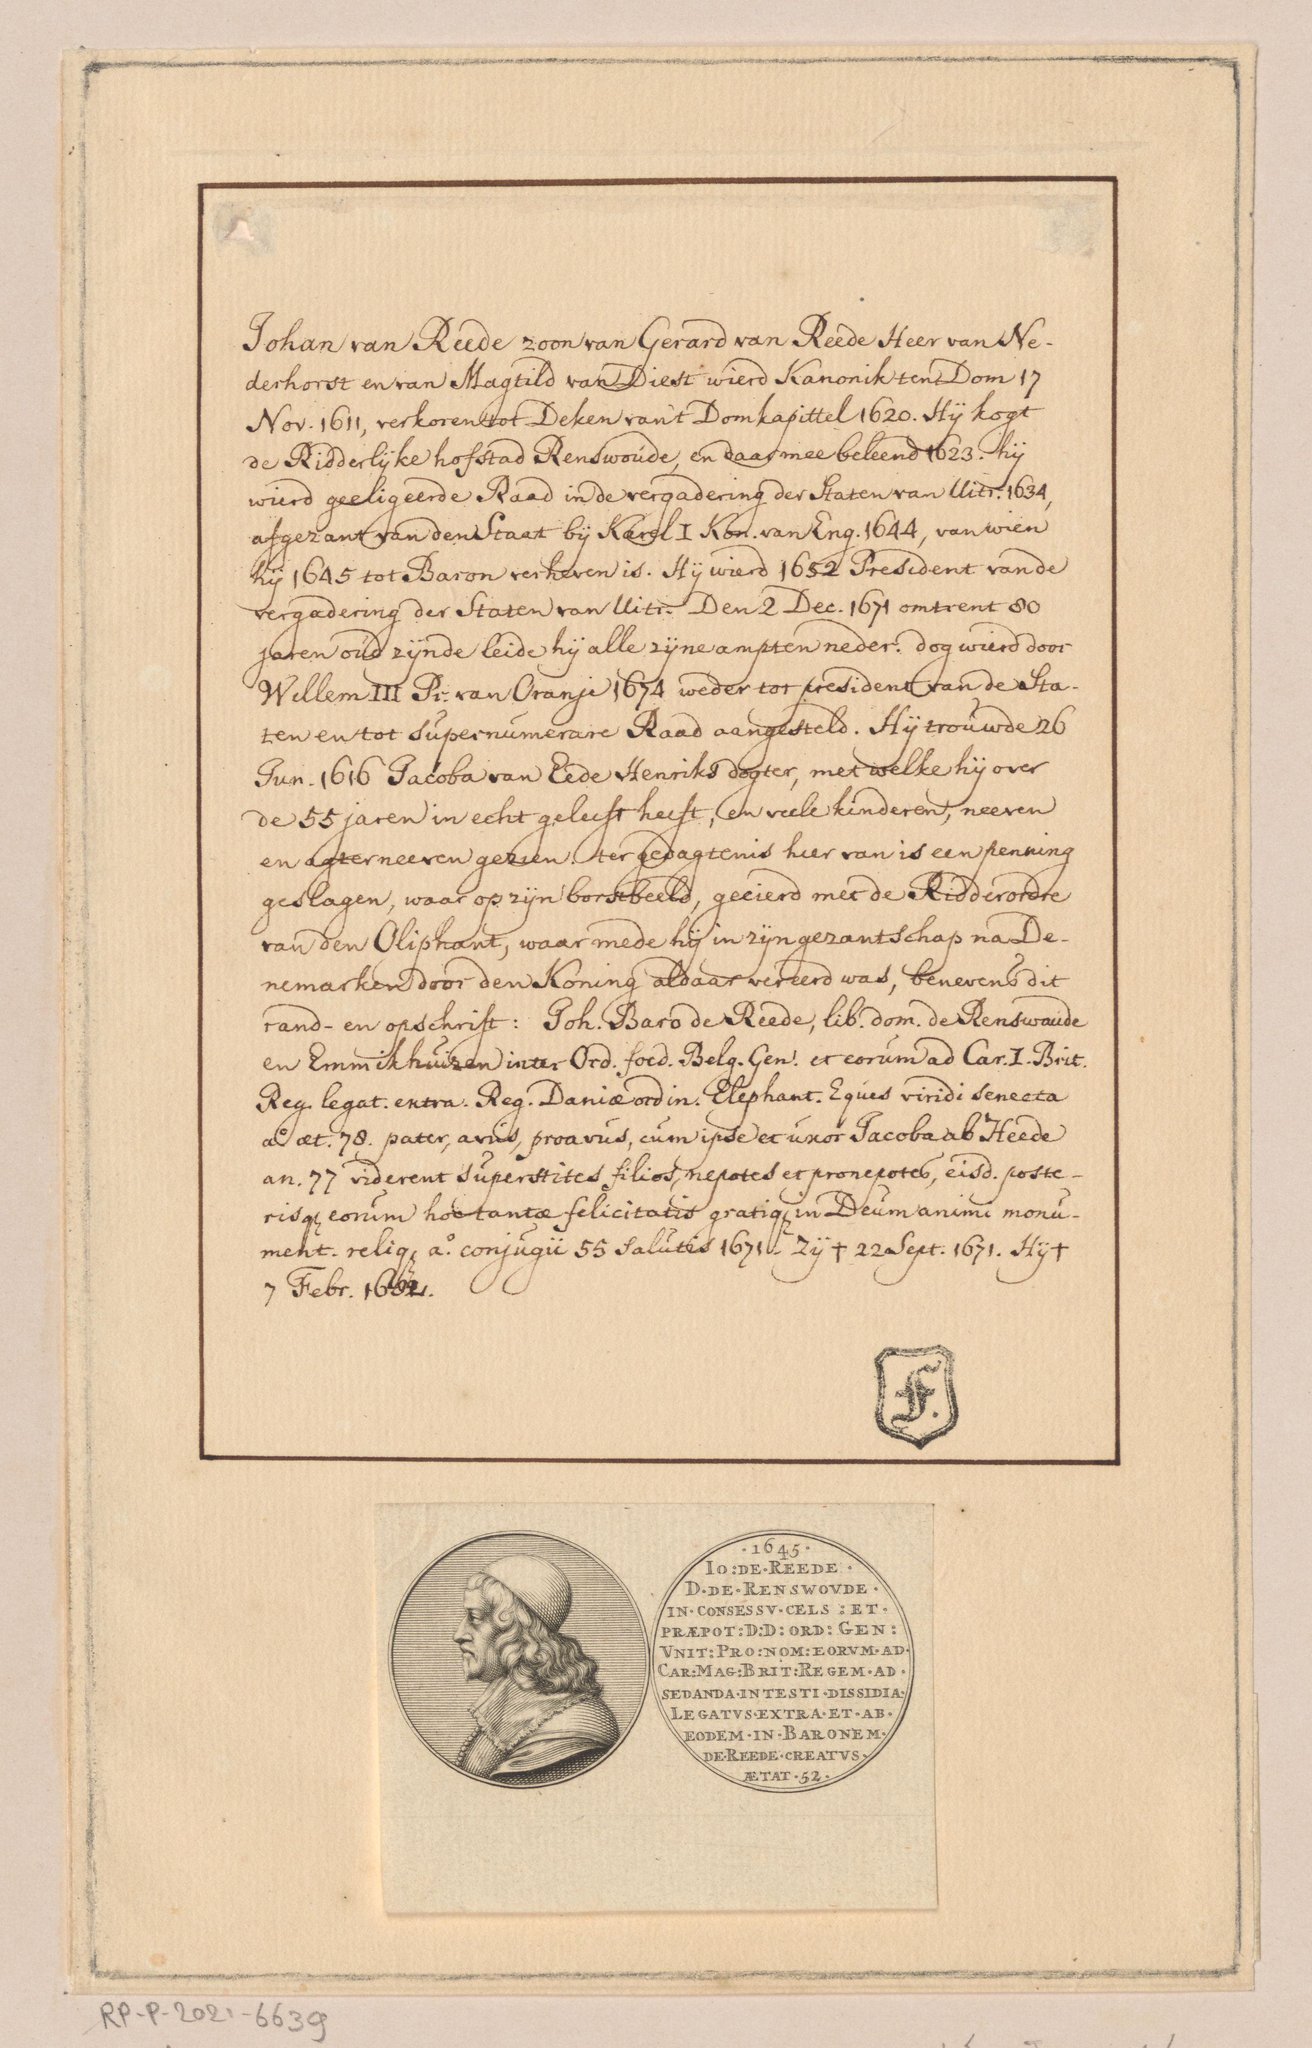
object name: print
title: Penning met portret van Johan baron van Reede van Renswoude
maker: Anonymous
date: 1726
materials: paper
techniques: etching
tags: johan baron van reede van renswoude, historical persons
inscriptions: collector's mark: Lugt 963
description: Prent met tekst op verso gebruikt in: Loon, Gerard van. Beschryving der Nederlandsche historipenningen (...). Den Haag: Christiaan van Lom, Isaac Vaillant, Pierre Gosse, Rutgert Christoffel Alberts en Pieter de Hondt, 1726, dl. 2.